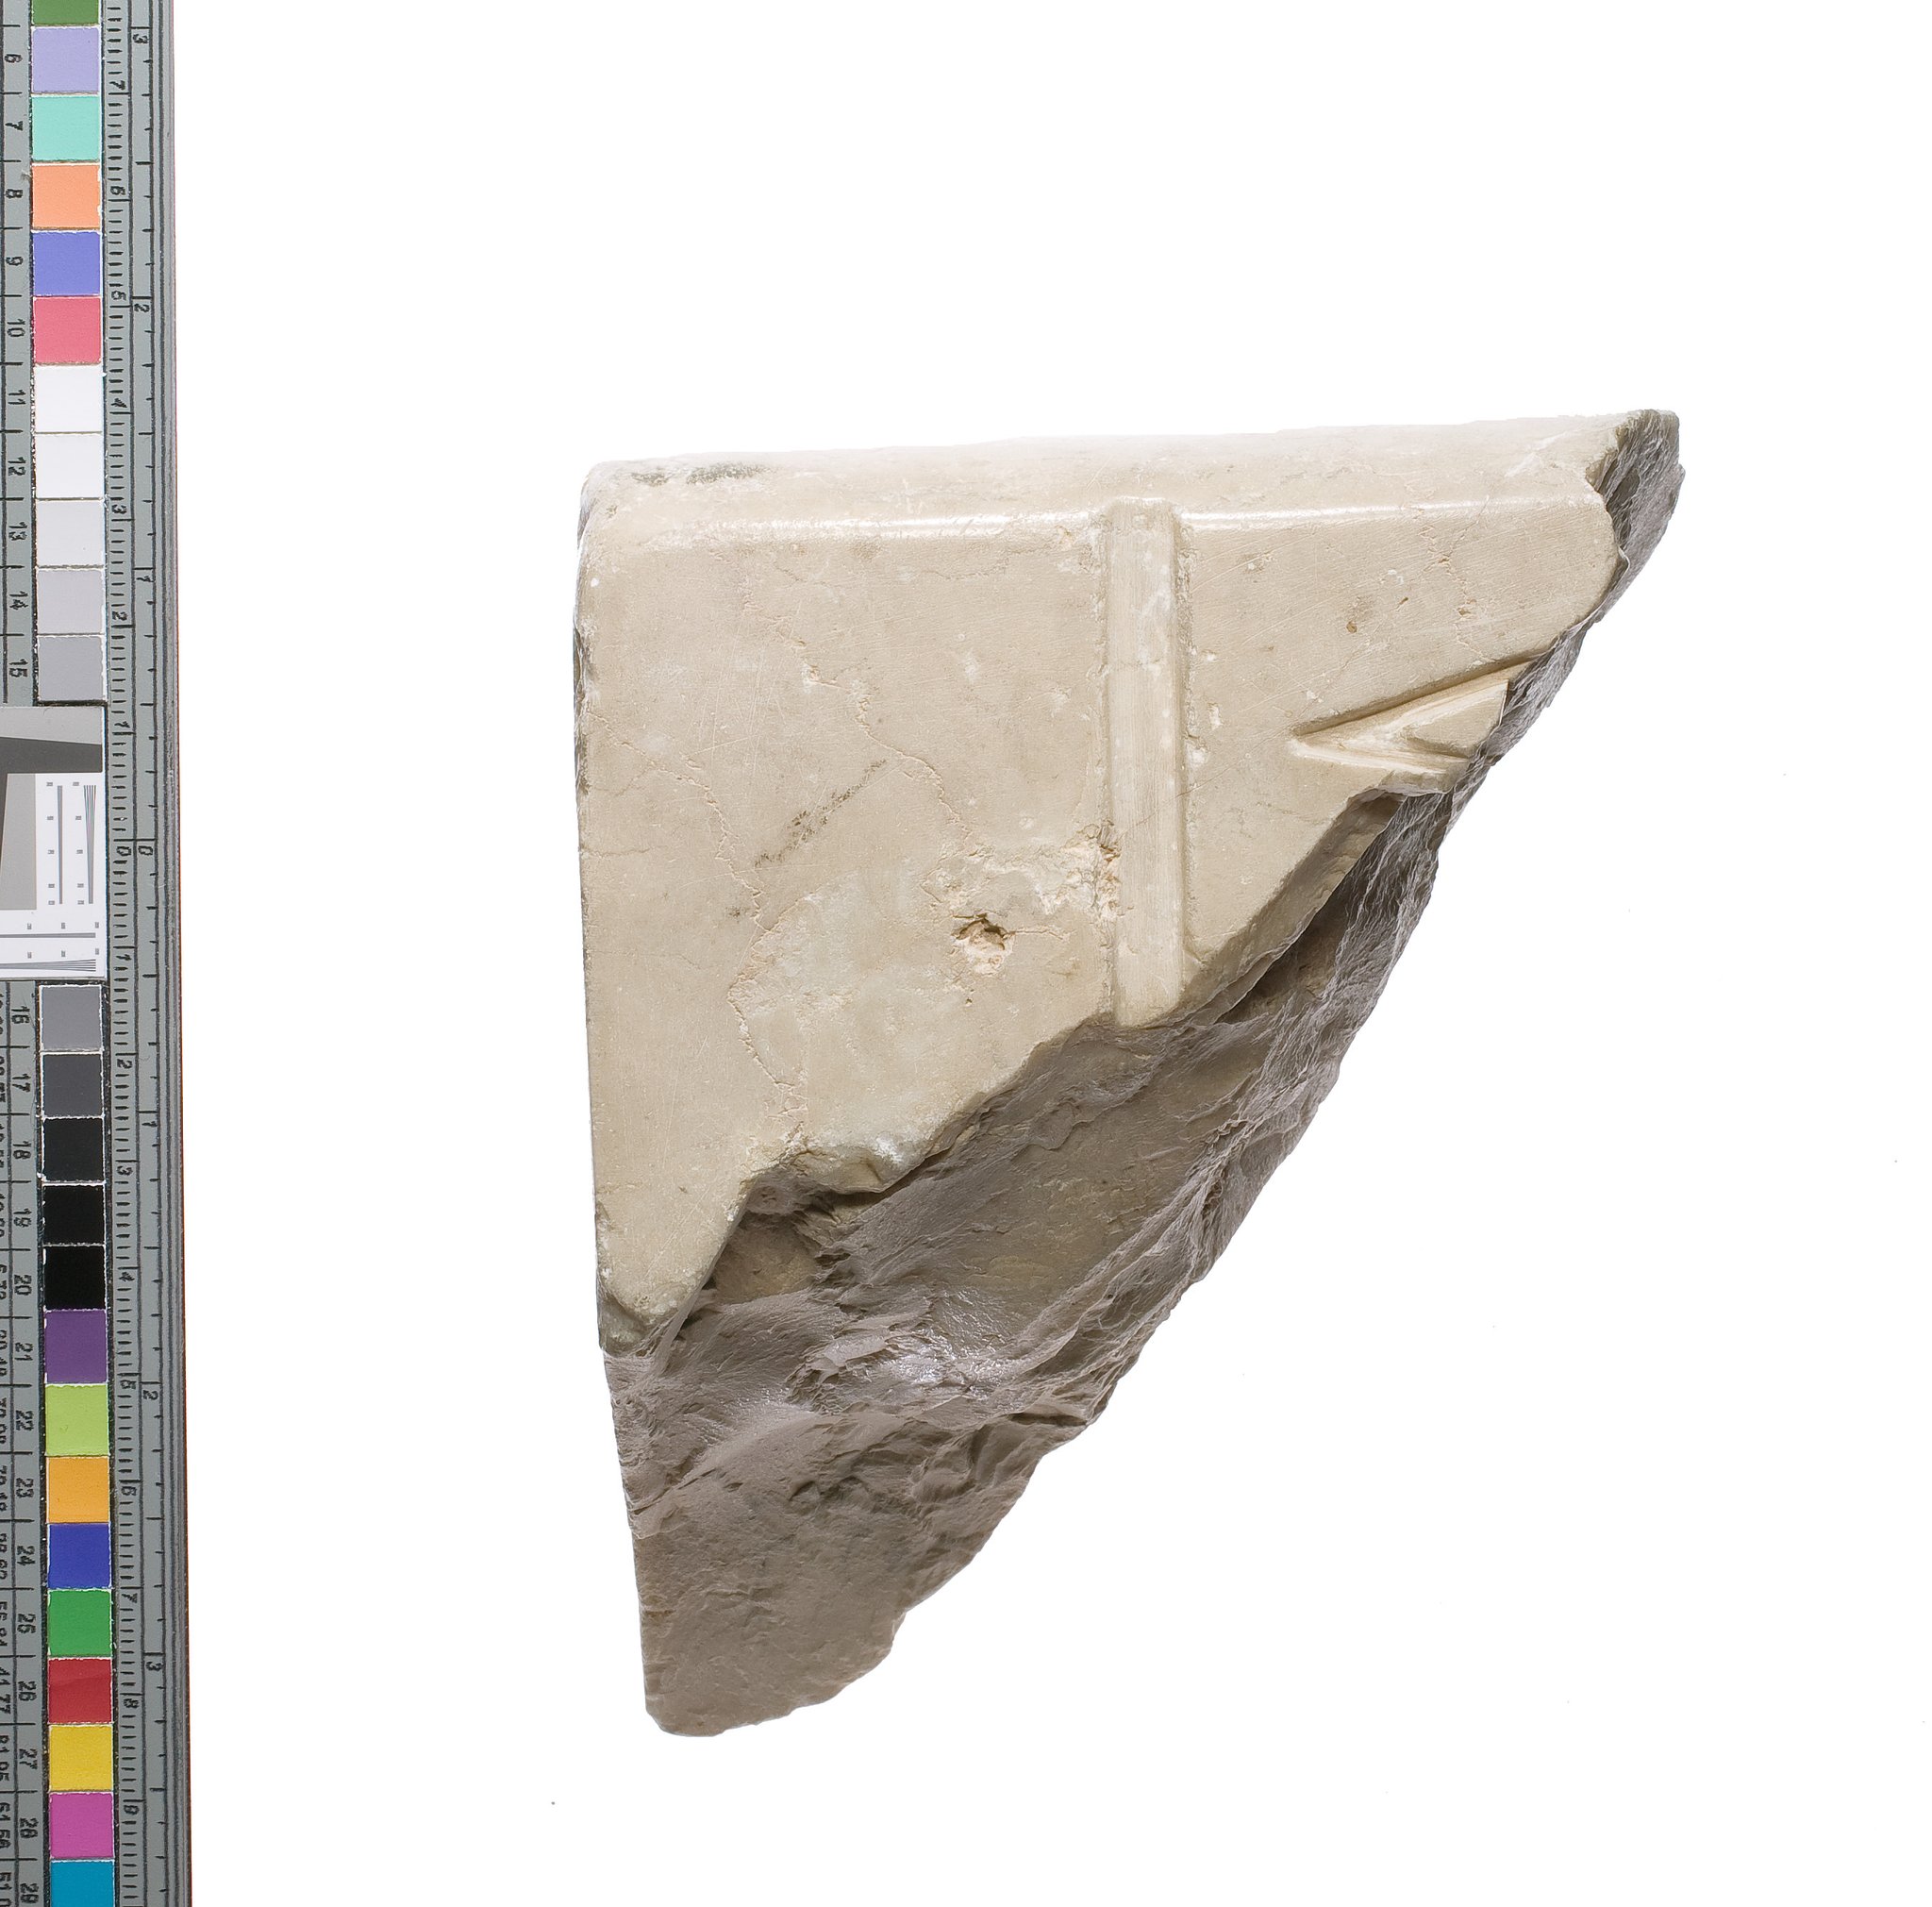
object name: throne back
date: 1353-1336 BCE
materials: limestone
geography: egypt